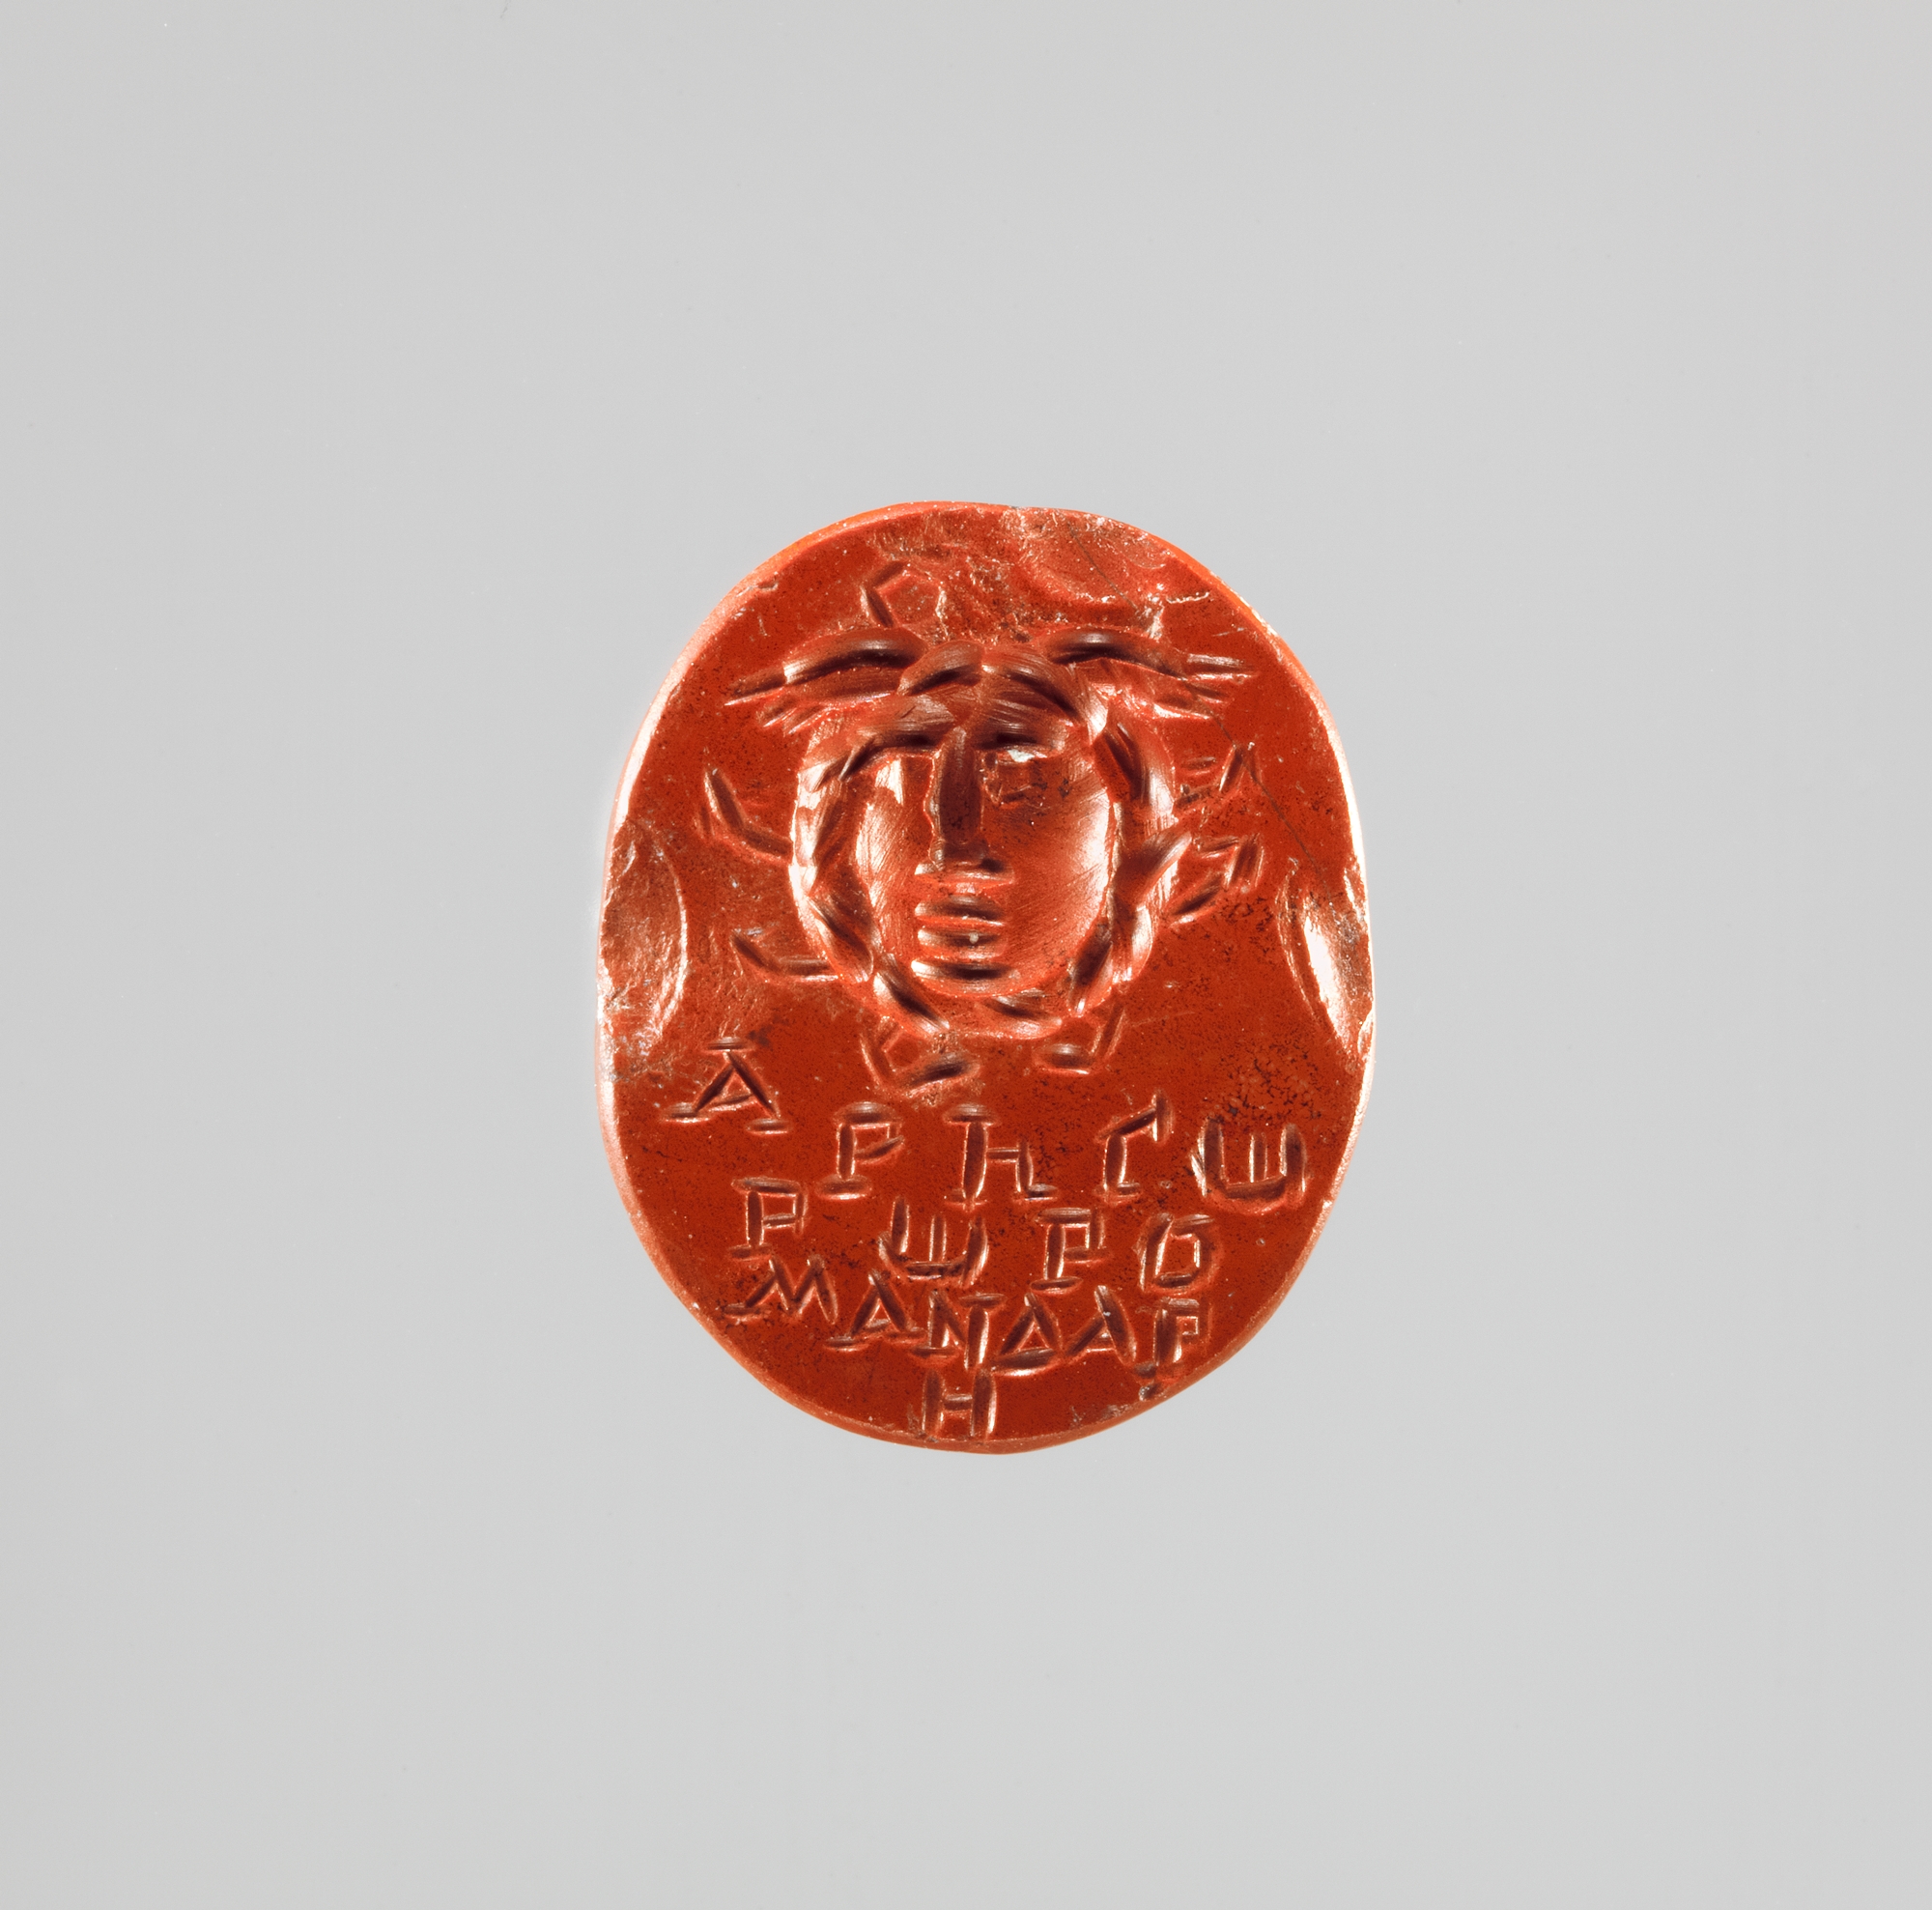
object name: intaglio, magical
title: Jasper intaglio: Head of Medusa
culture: roman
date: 101-300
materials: jasper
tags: heads,medusa